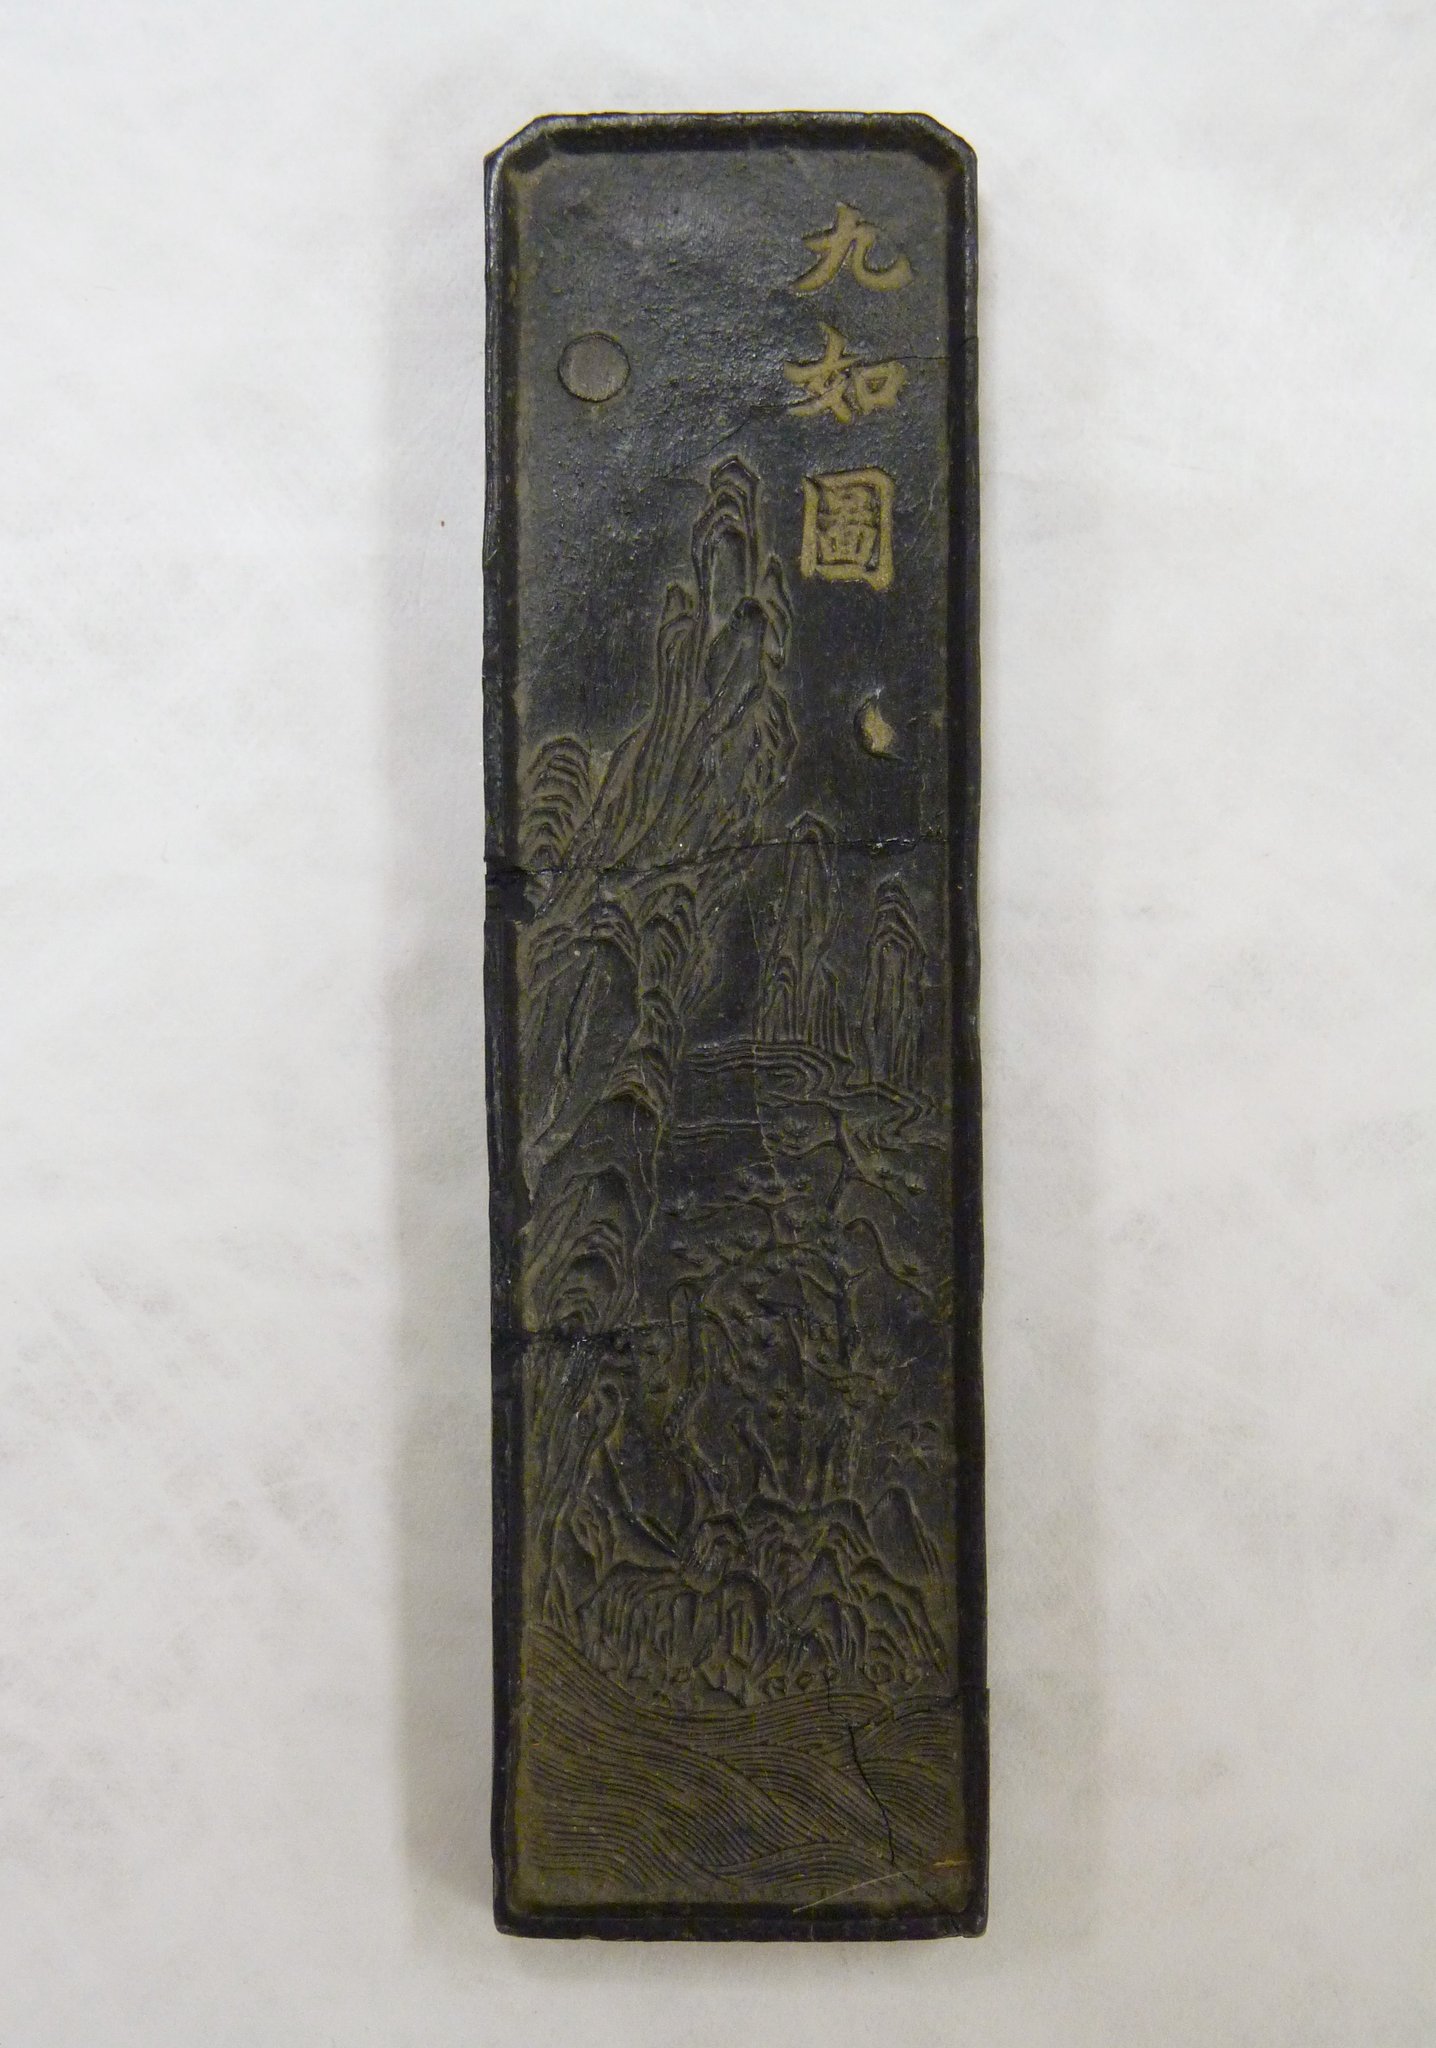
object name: ink tablet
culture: chinese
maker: xiu fangzhai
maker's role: artist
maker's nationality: chinese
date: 1867-1933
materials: ink